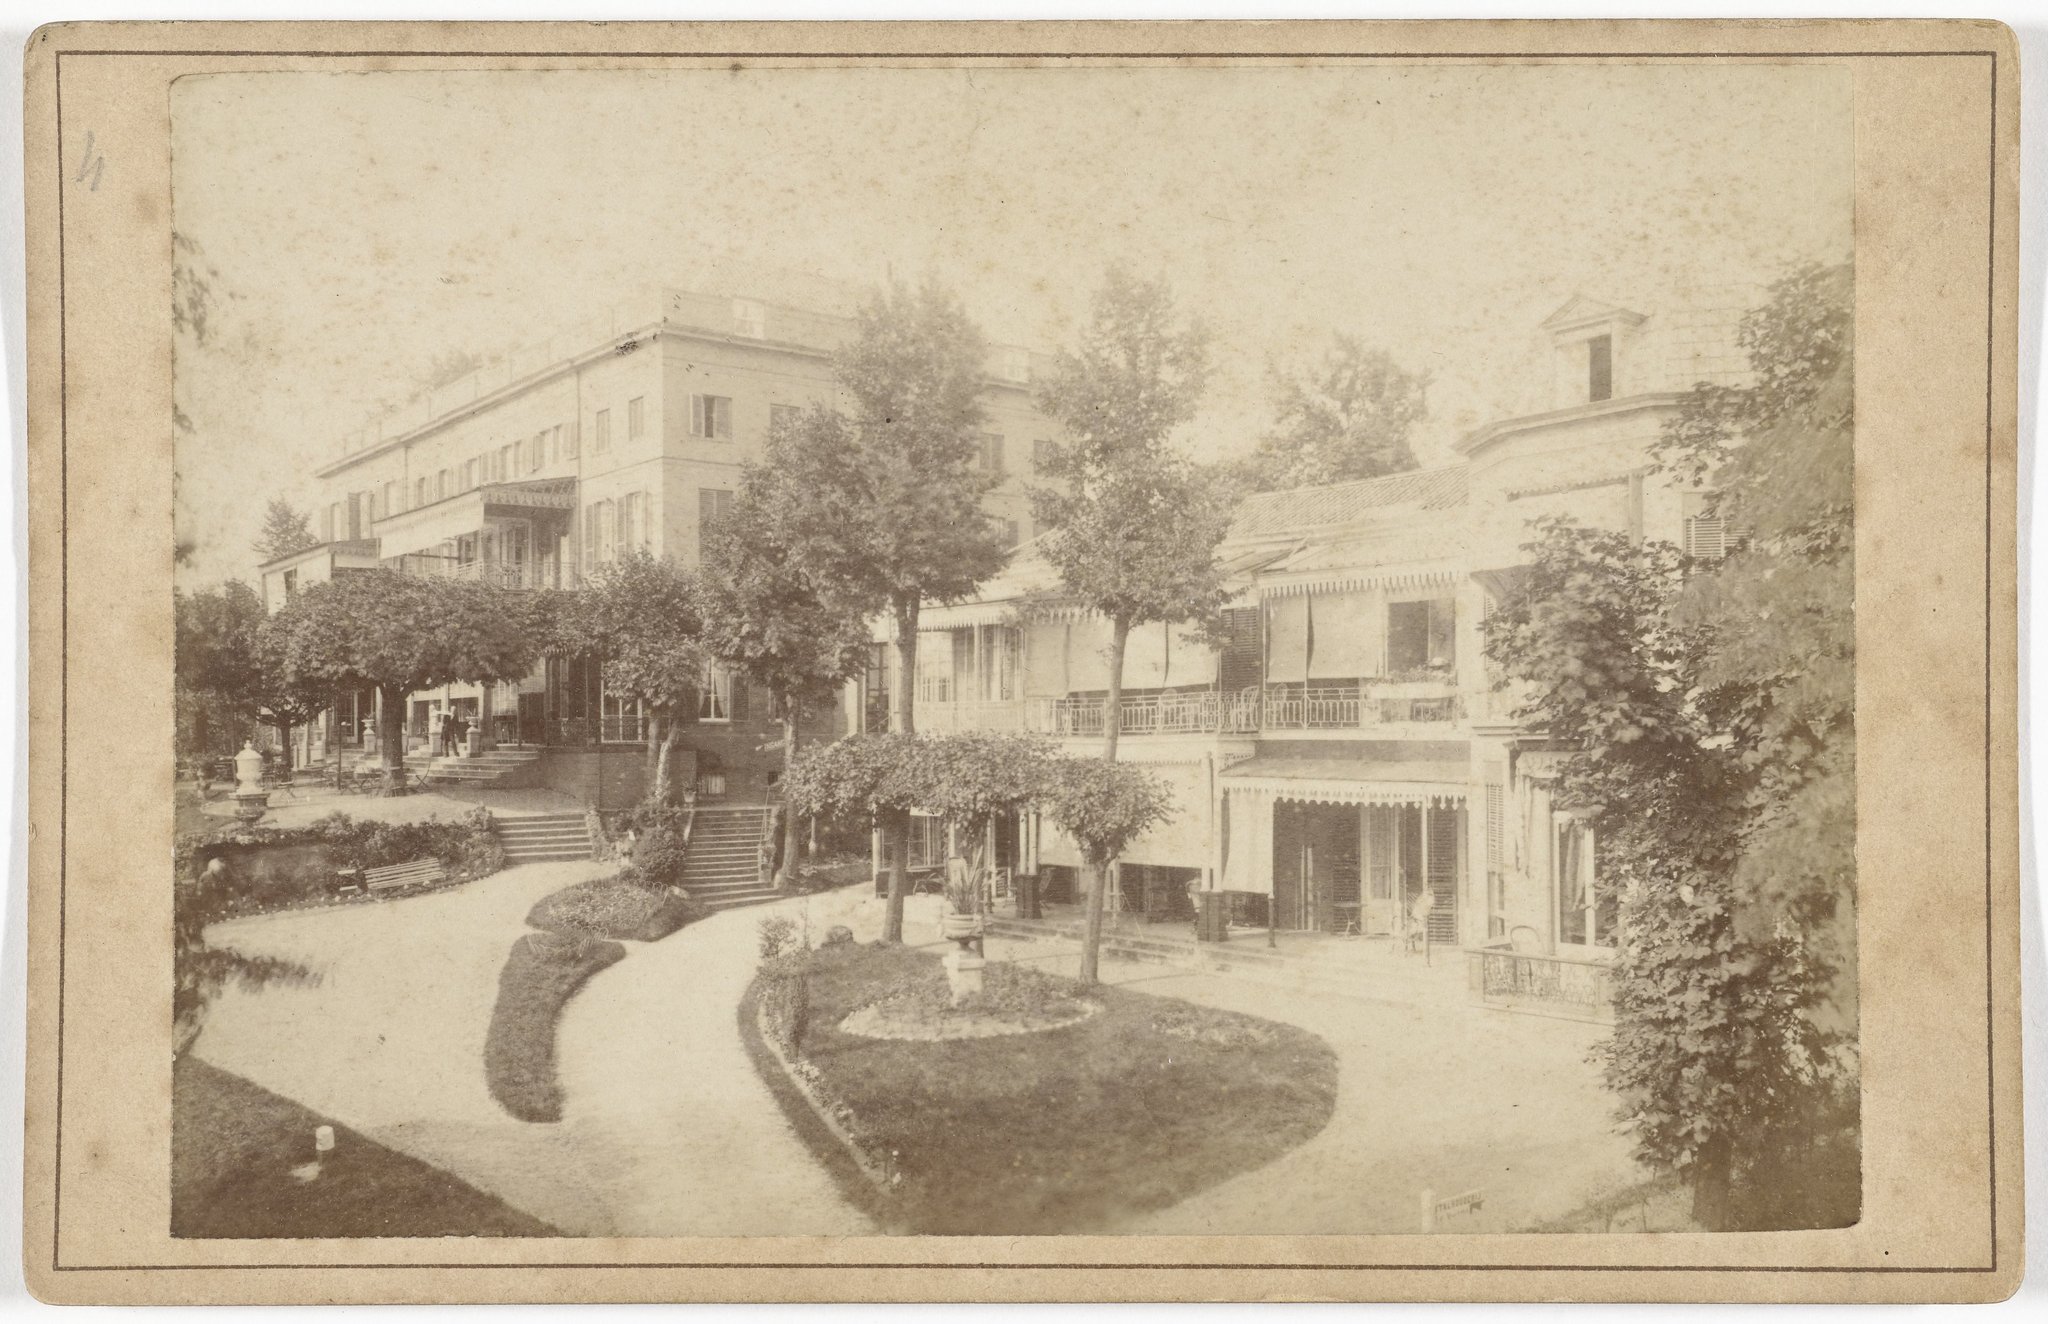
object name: photograph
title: Hotel Belle Vue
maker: j.s.j. de jongh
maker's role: fotograaf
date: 1860-1880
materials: cardboard, paper, photographic support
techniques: albumen print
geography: arnhem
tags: village square, place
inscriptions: annotation: ‘Hotel Belle Vue’, signature: ‘J.S.J. de Jongh W. Jzn., Arnhem’, annotation: ‘No. 11 [cijfer met de hand ingevuld]’, name: ‘Vosmaer’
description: Hotel Bellevue aan de Utrechtseweg te Arnhem